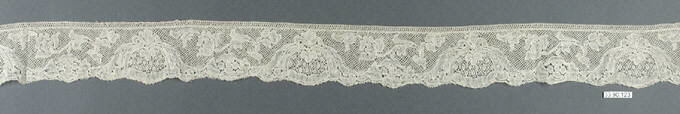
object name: edging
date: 1701-1733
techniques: lace